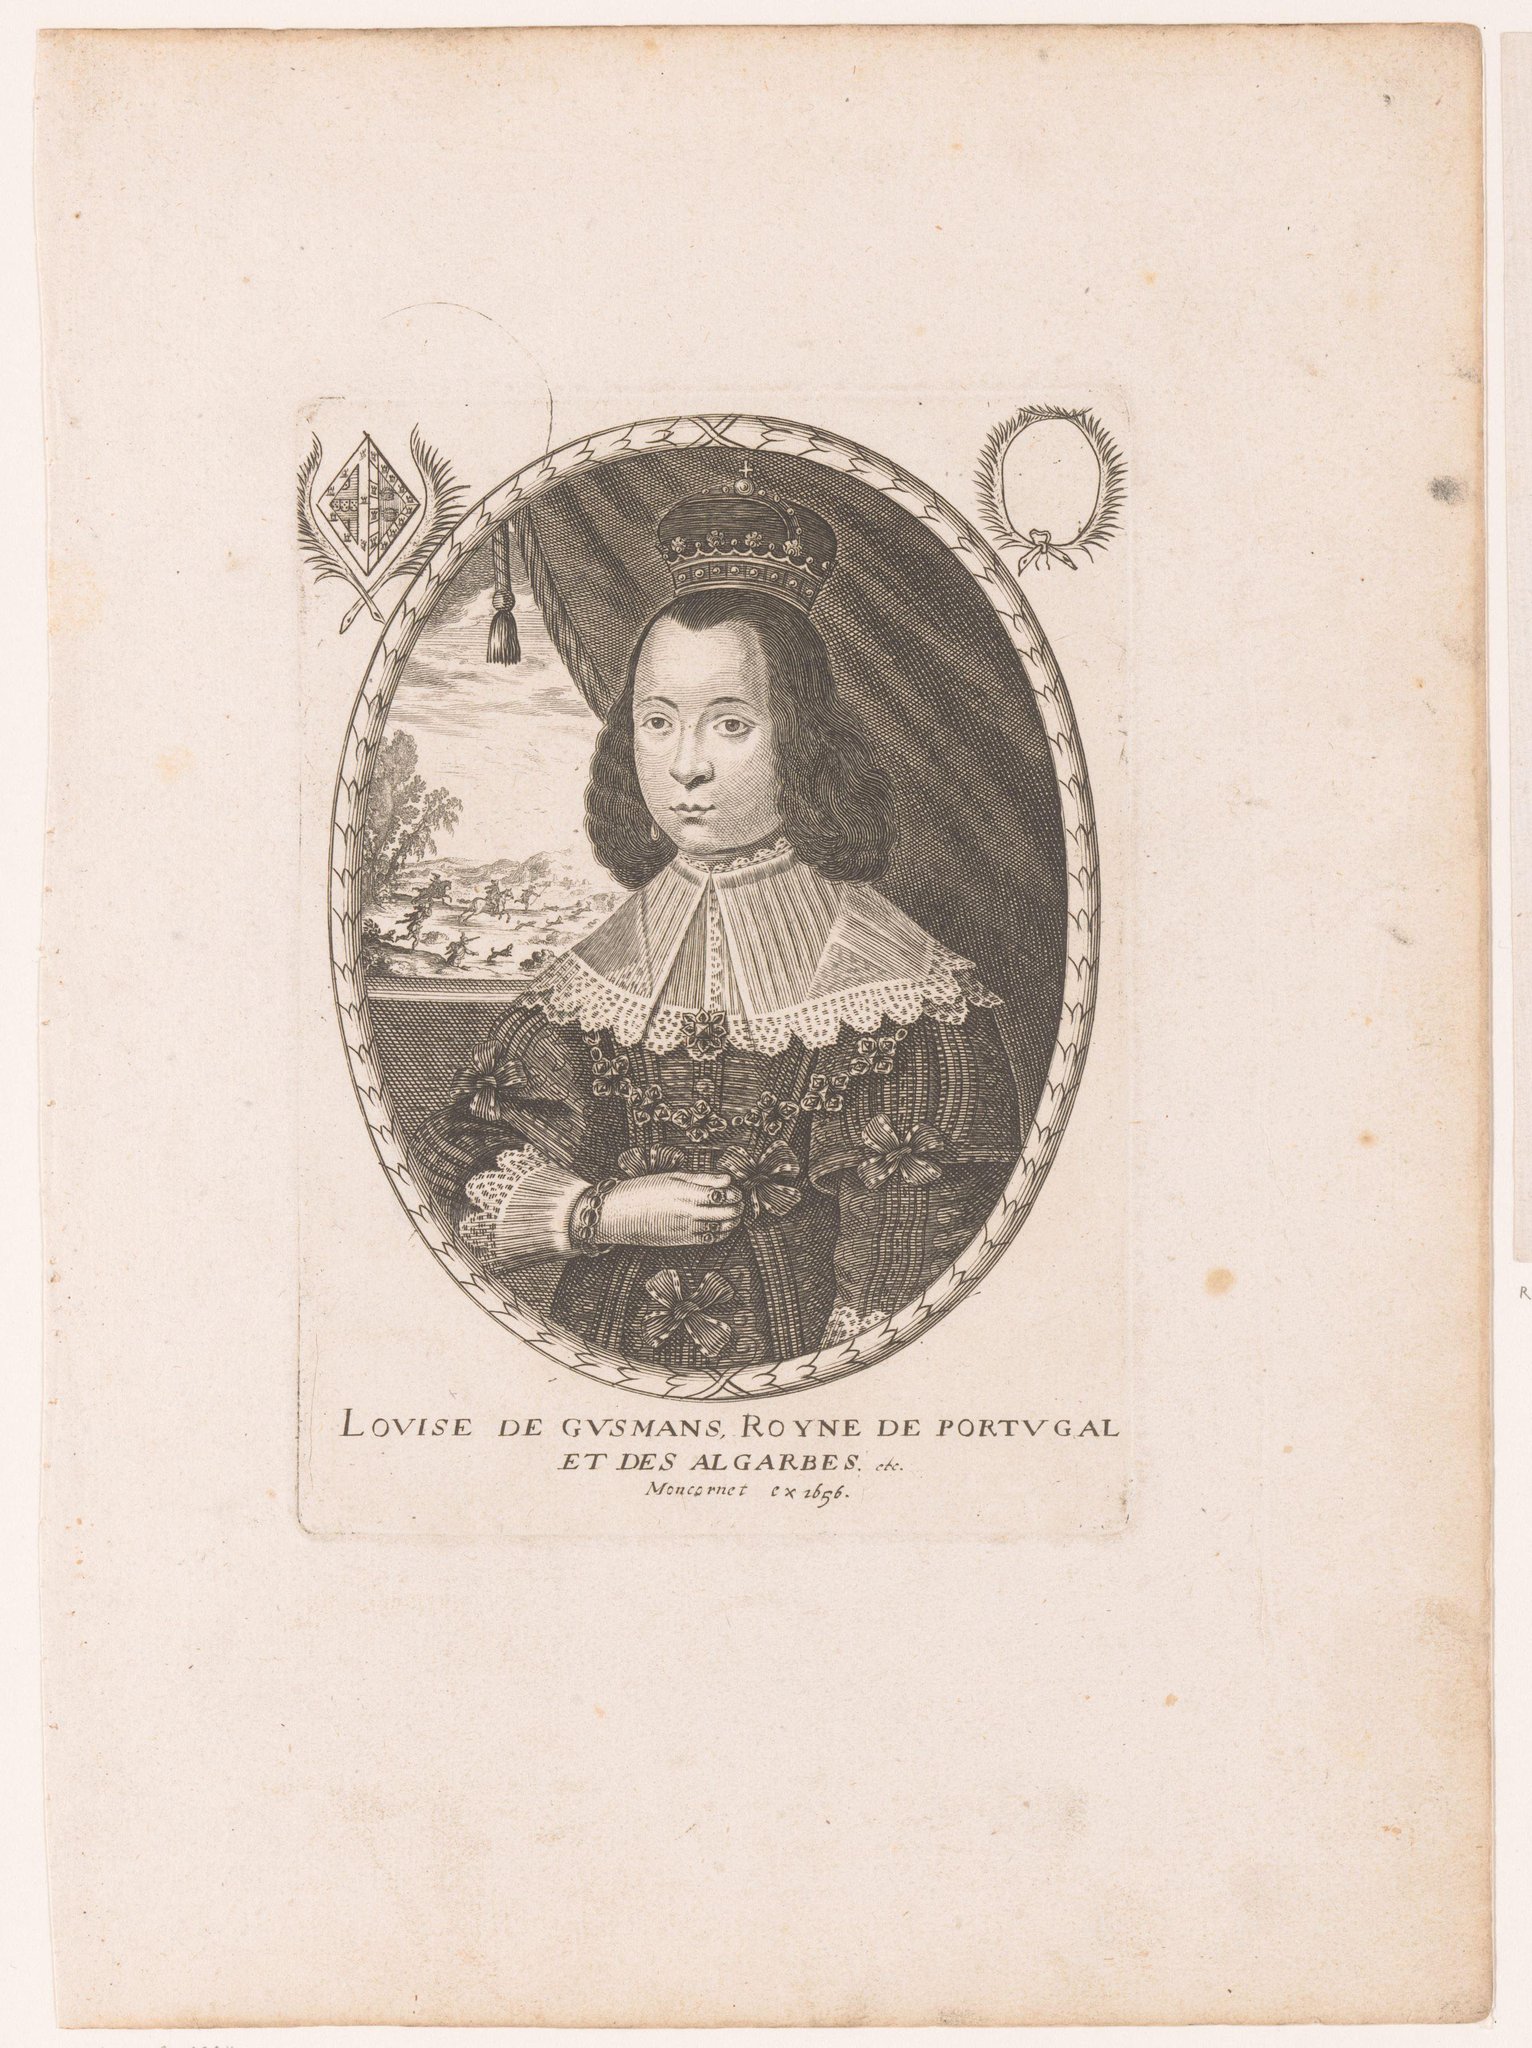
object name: print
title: Portret van Luisa de Guzmán, koningin van Portugal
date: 1656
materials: paper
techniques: engraving, etching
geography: paris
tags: historical persons - bb - woman, queen, armorial bearing, heraldry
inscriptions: collector's mark: Lugt 2228